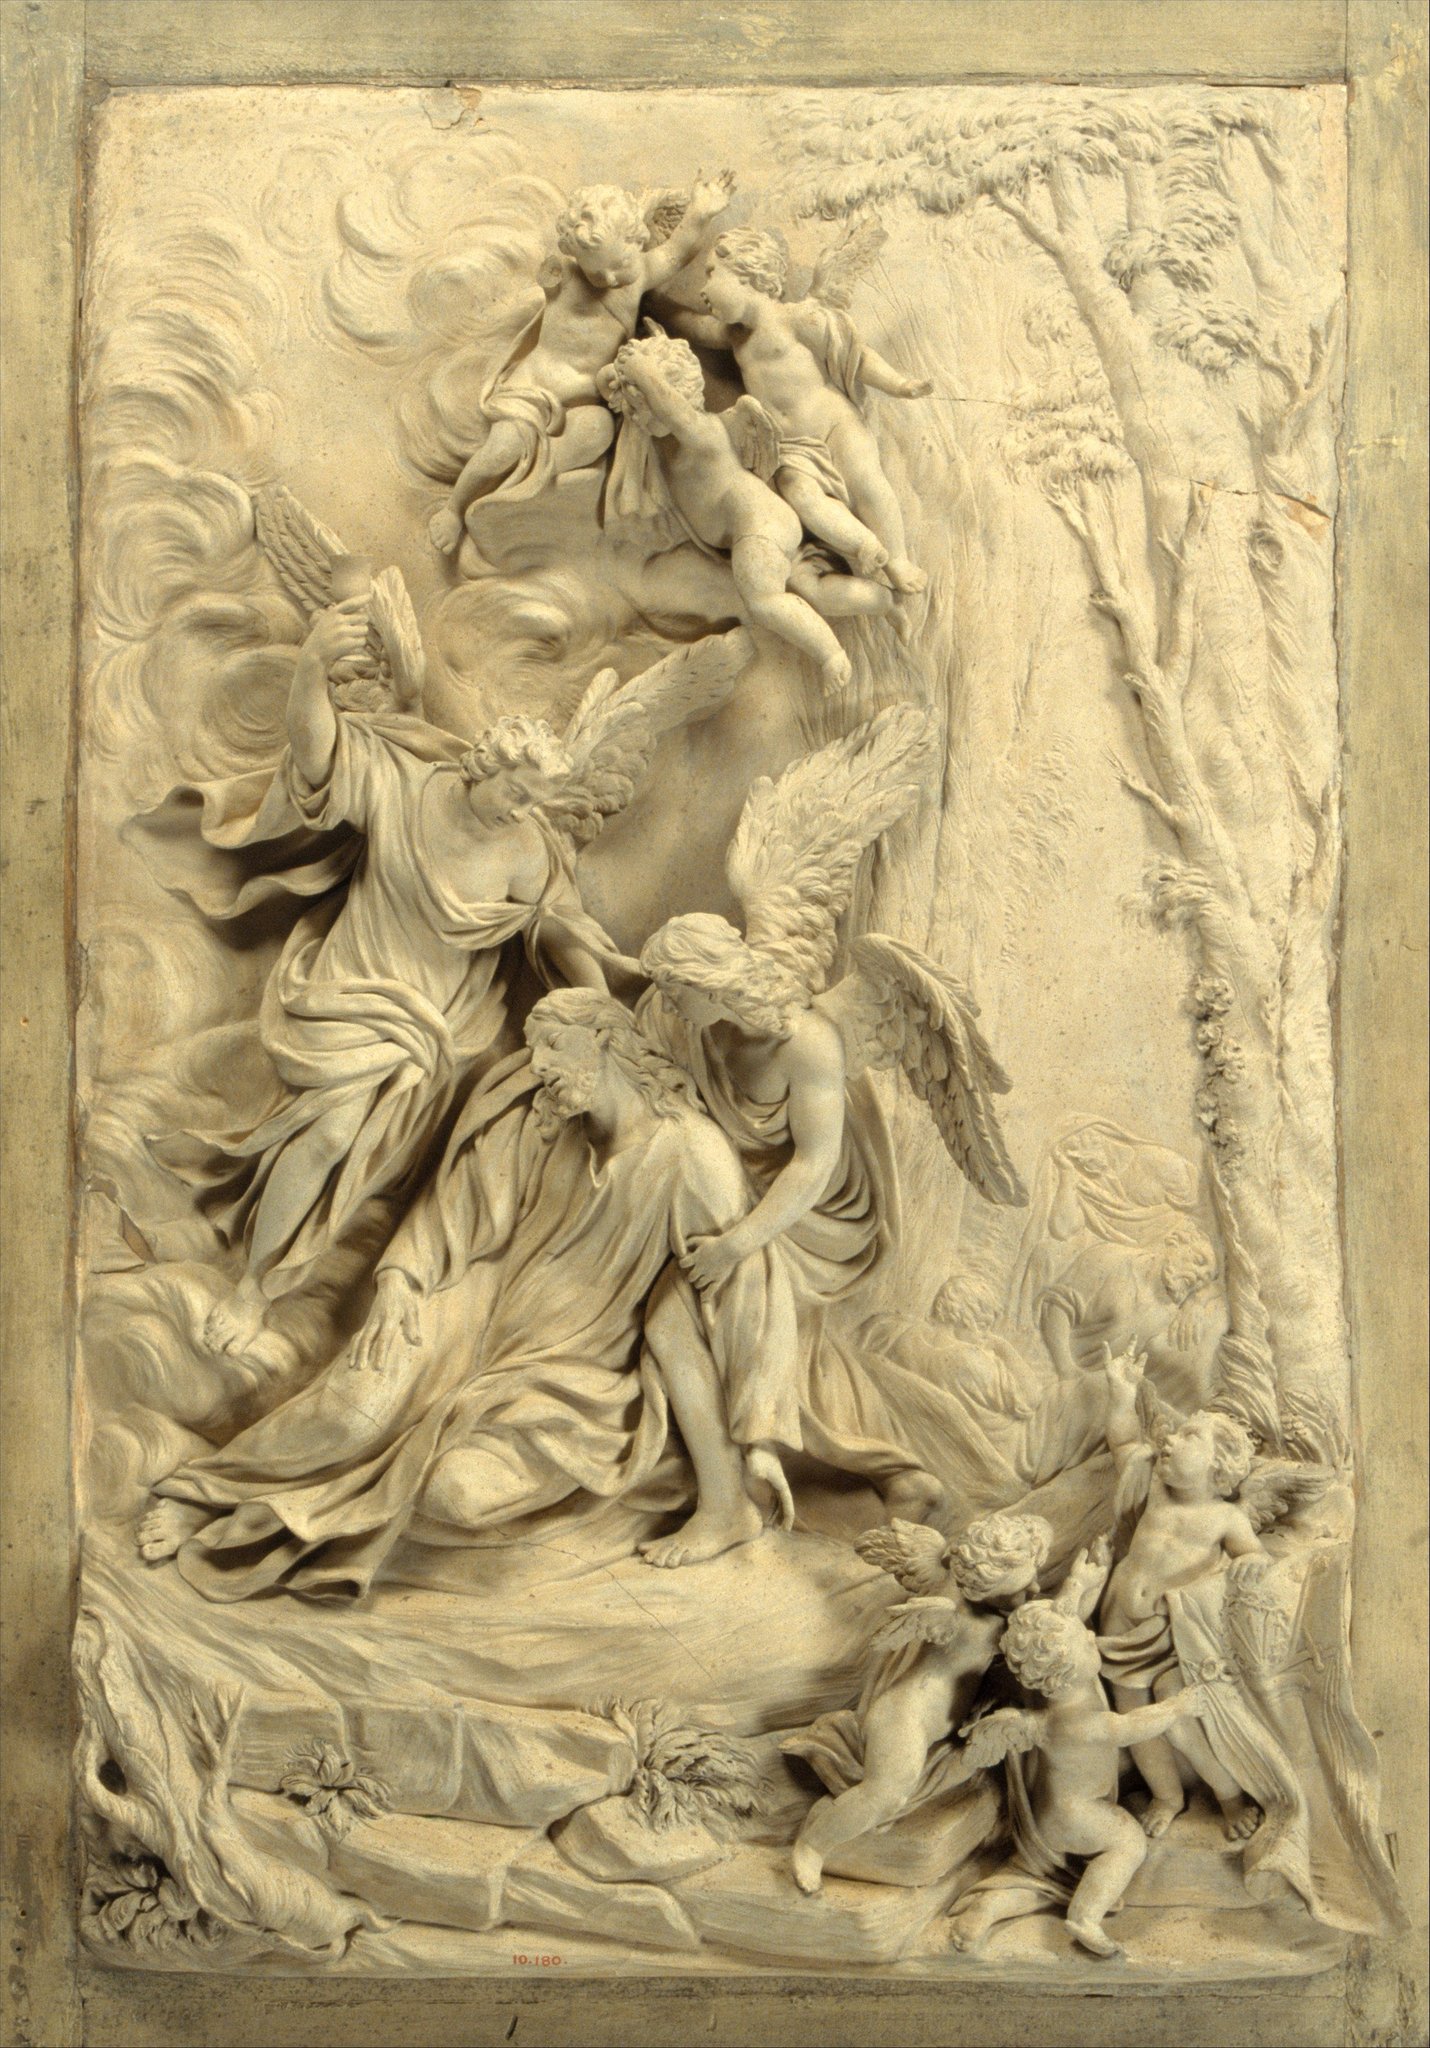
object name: relief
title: The Agony in the Garden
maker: massimiliano soldani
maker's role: artist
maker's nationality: italian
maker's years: 1656-1740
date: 1701-1733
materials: terracotta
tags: angels,christ,agony in the garden